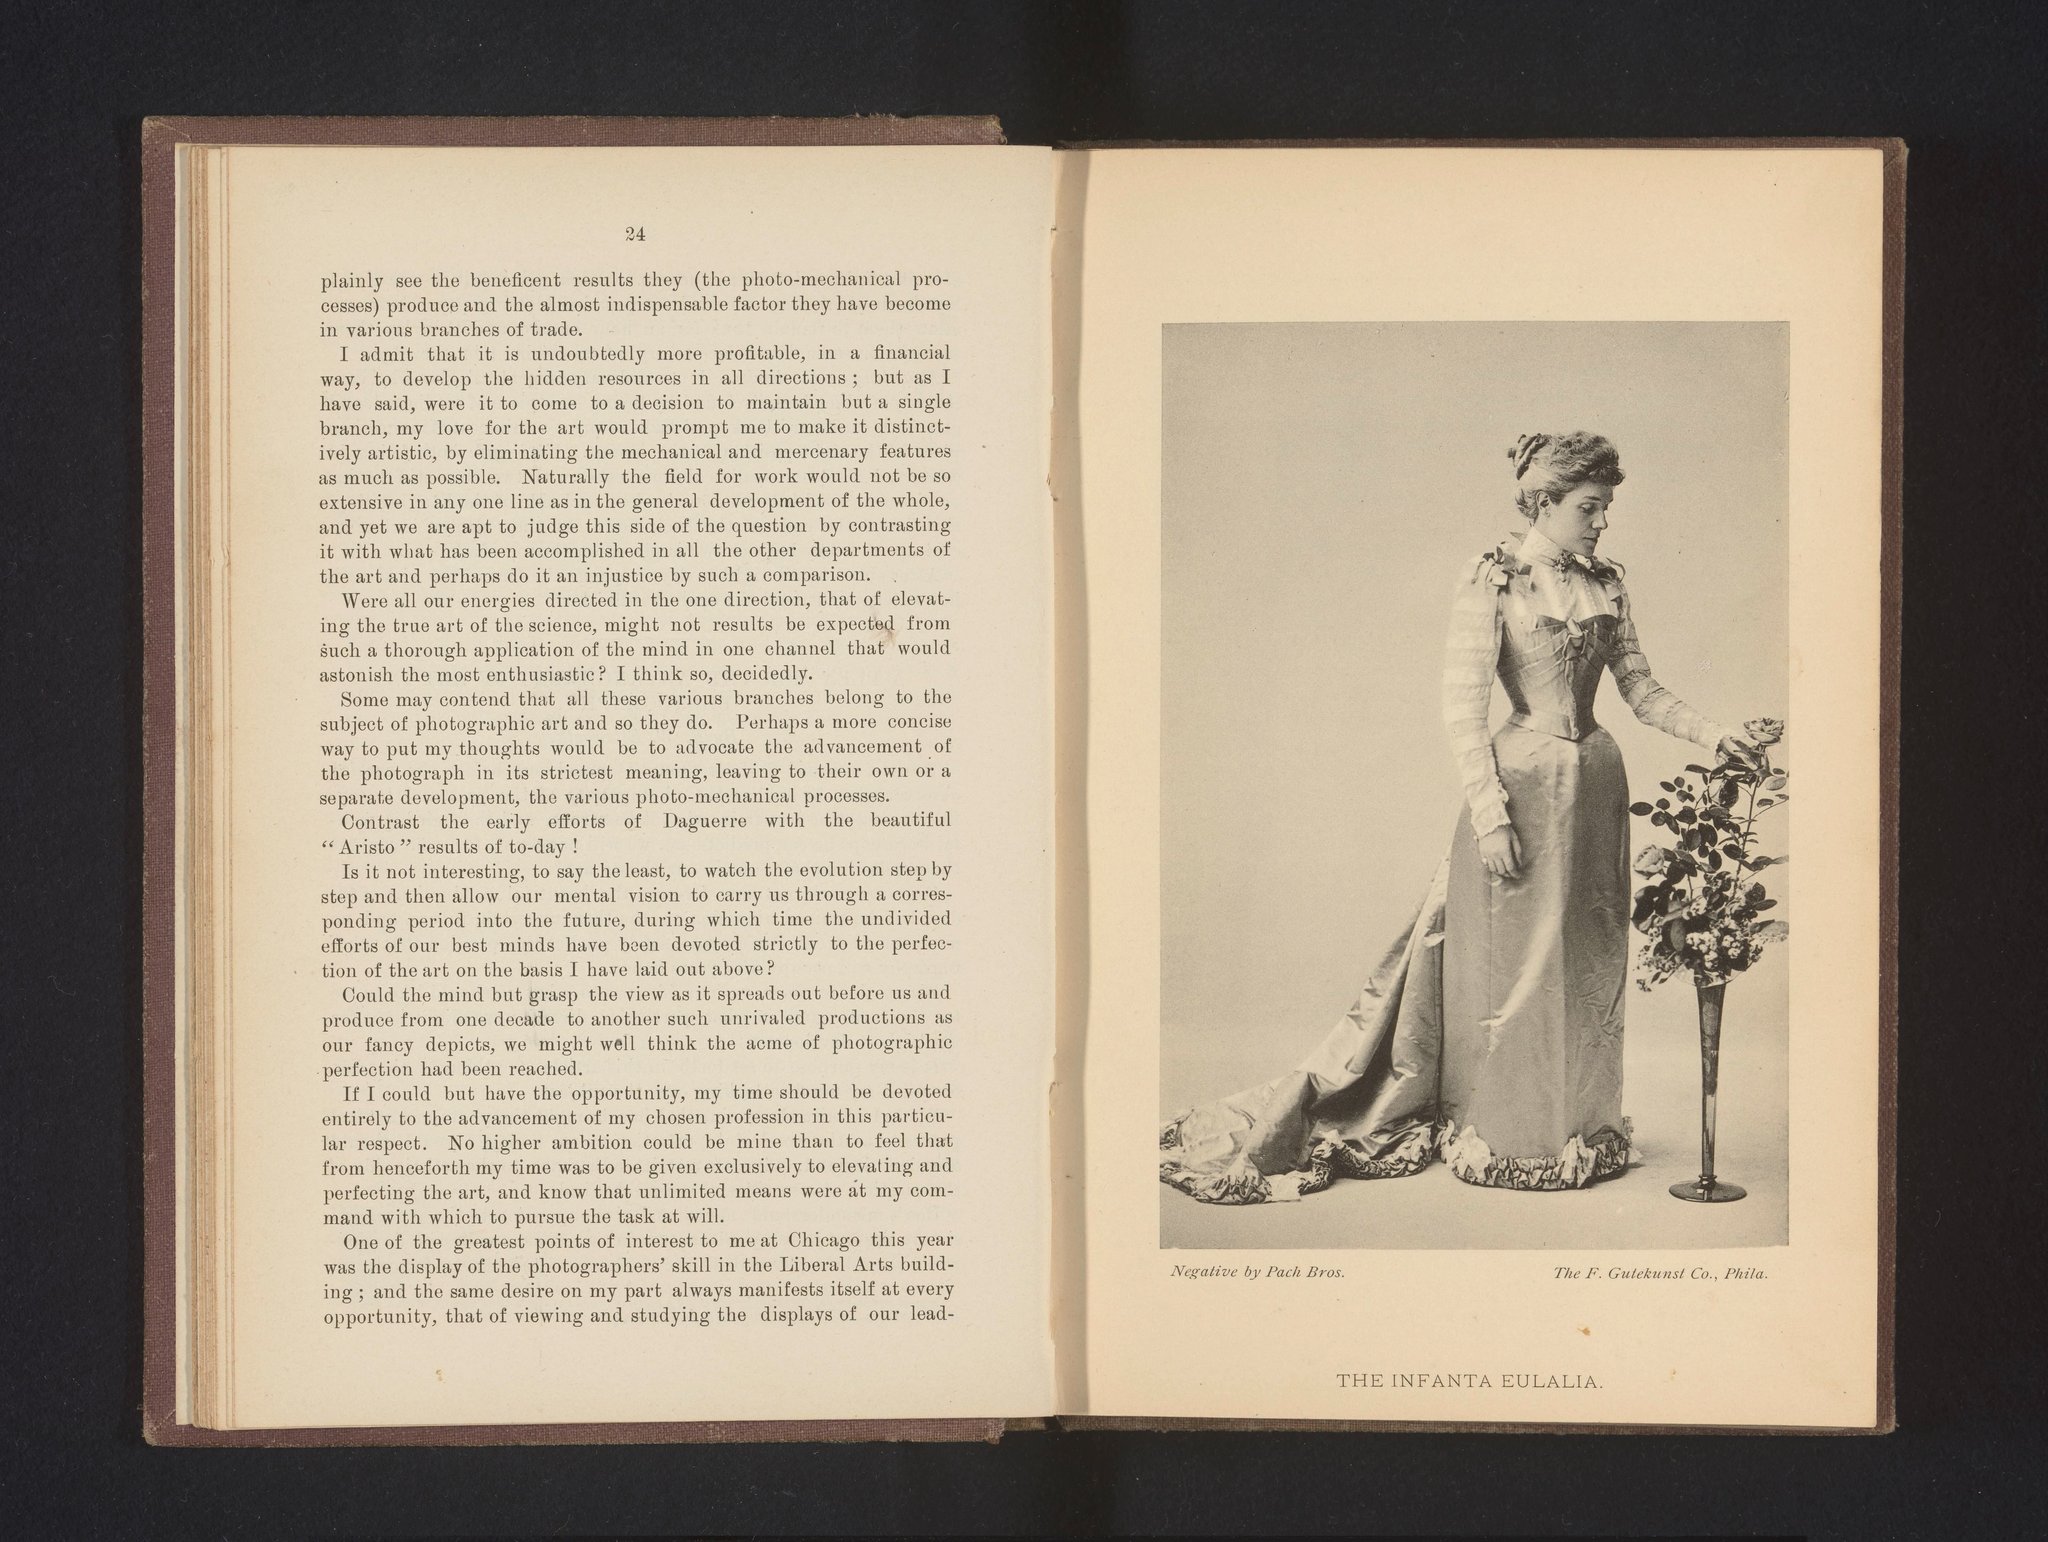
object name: page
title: The infanta Eulalia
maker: g.w. pach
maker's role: publisher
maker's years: 1845-1904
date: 1888-1893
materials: paper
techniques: photograph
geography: philadelphia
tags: ruler, sovereign - bb - female ruler